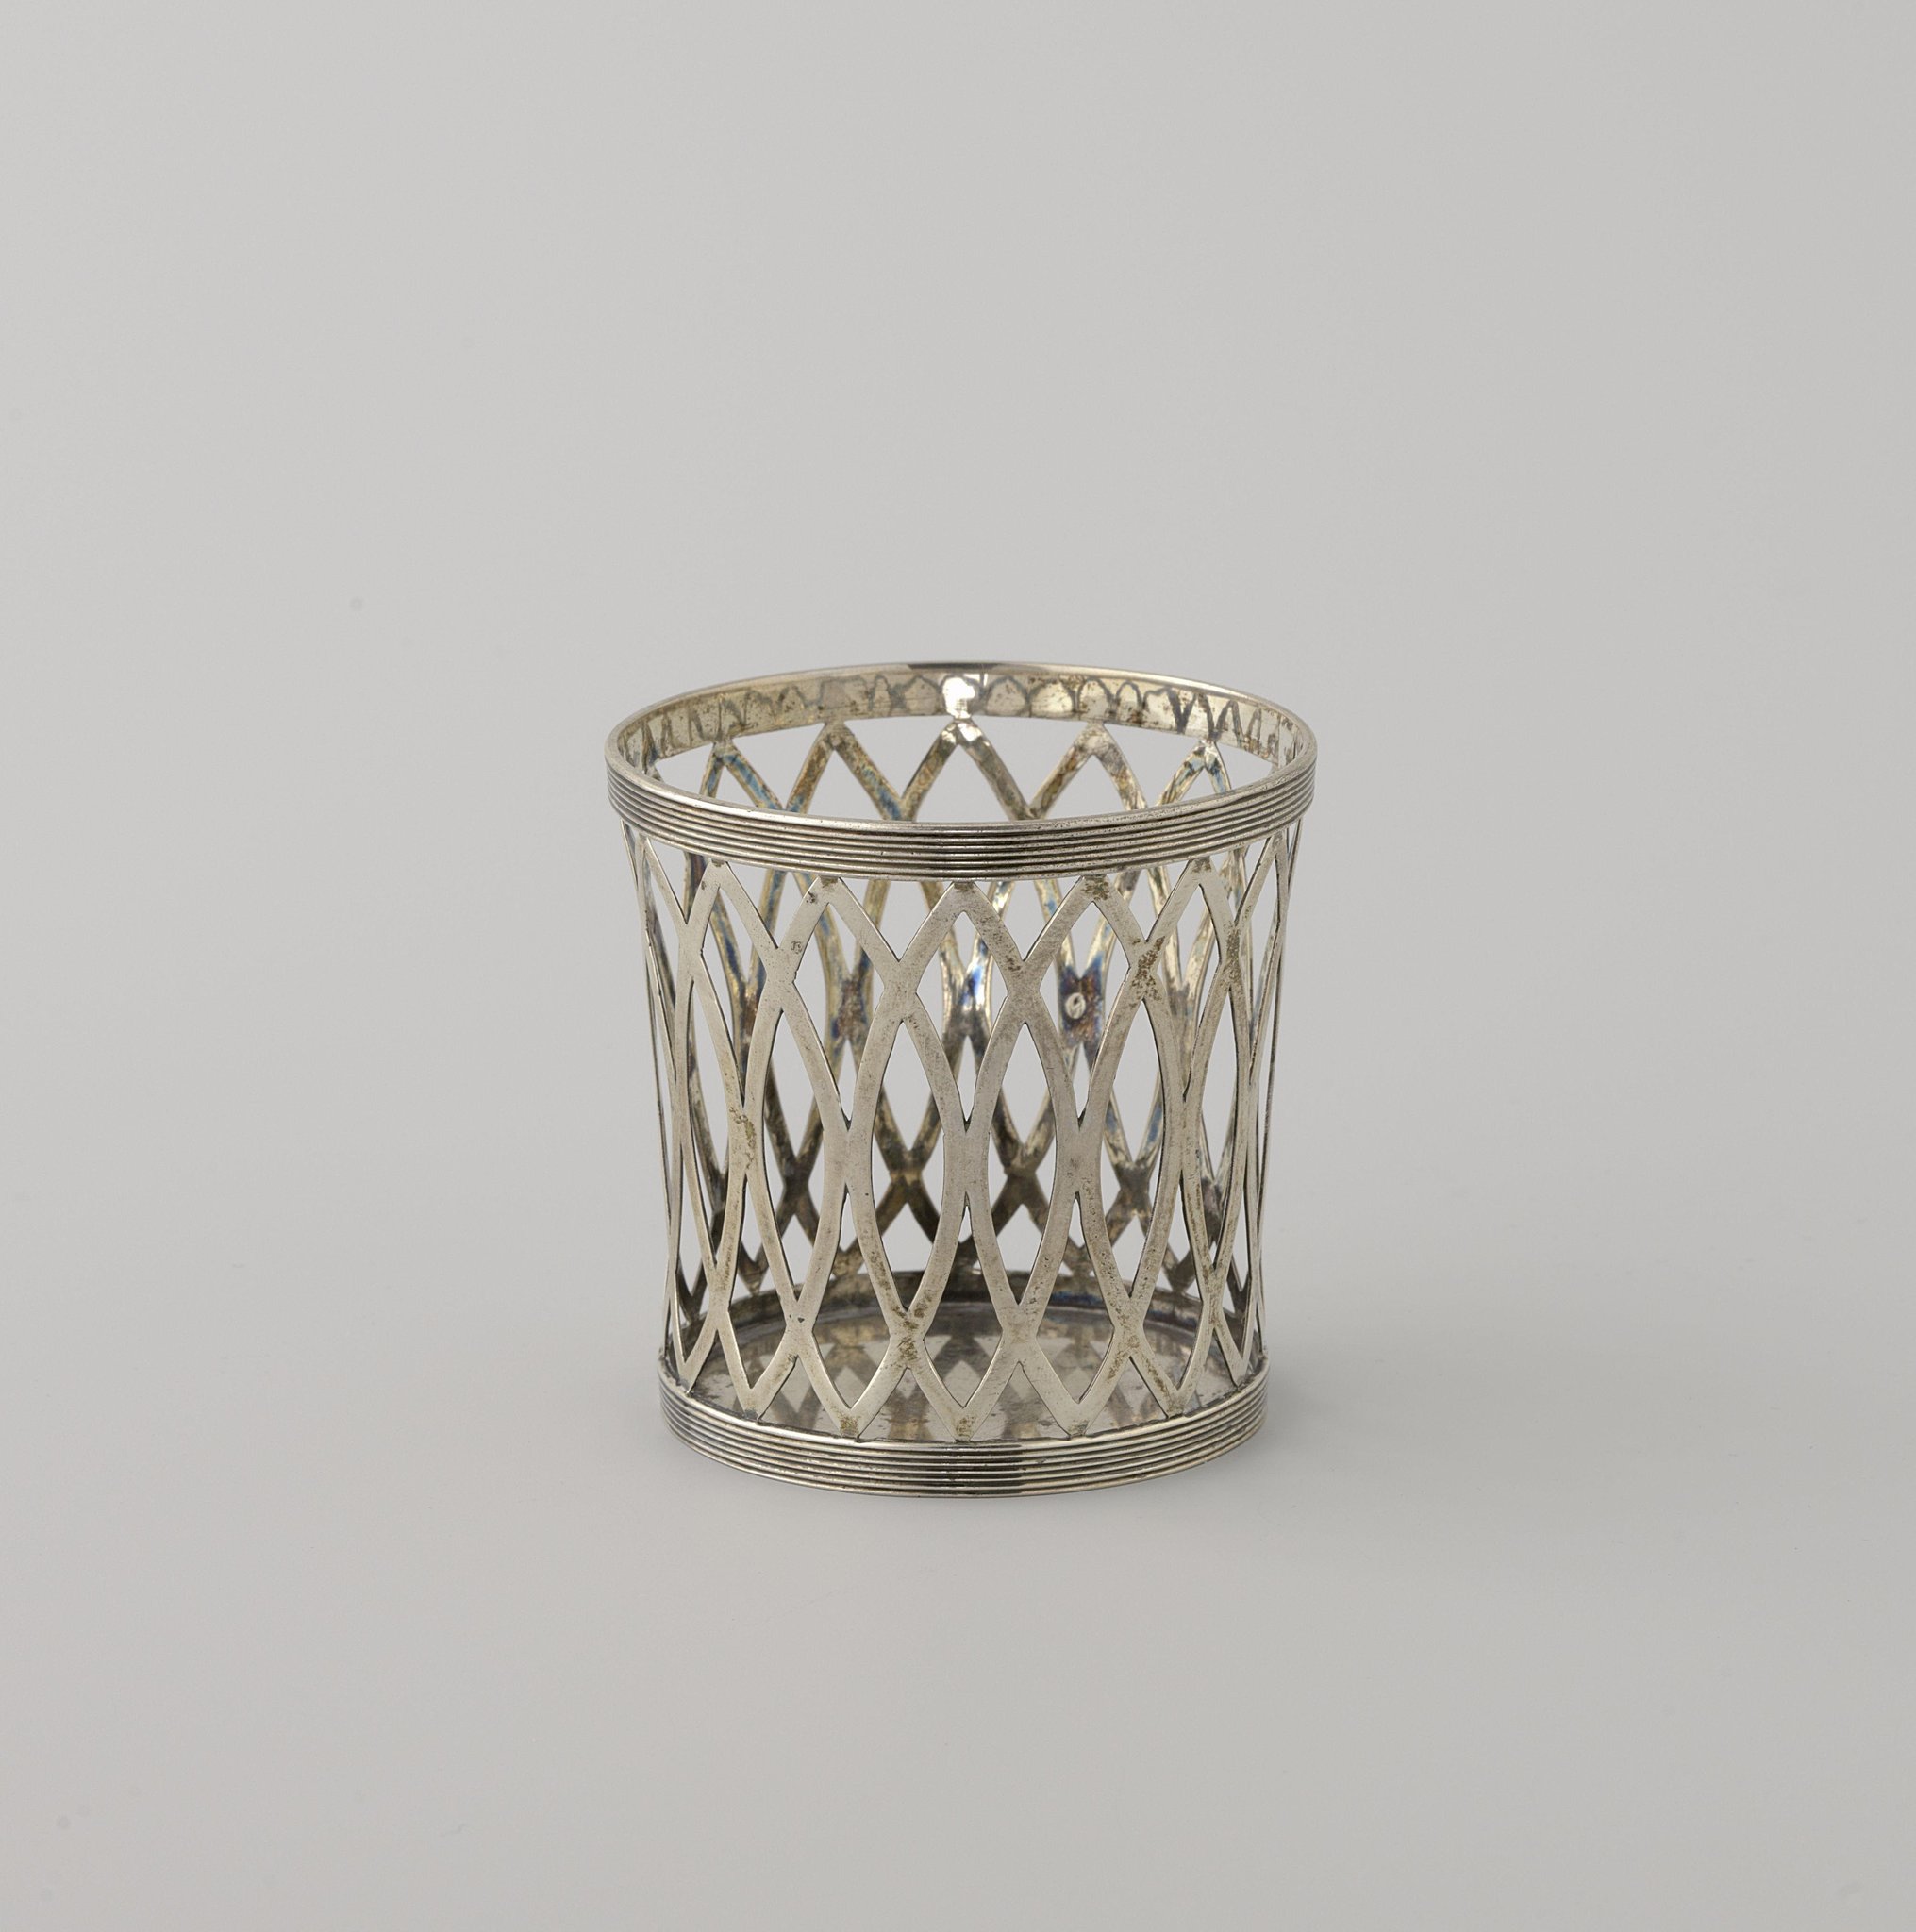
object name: basket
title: Twee kleine (B en D) en twee grotere (A en C) manden of houders, à jour bewerkt met dooreengeslingerde ovalen en filetranden langs onder- en bovenzijde.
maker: Anonymous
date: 1800-1825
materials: silver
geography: netherlands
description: Twee kleine (B en D) en twee grotere (A en C) manden of houders, à jour bewerkt met dooreengeslingerde ovalen en filetranden langs onder- en bovenzijde. Nederland?, eerste kwart 19de eeuw. Gemerkt op buitenzijde wand: herkeur zwaard.